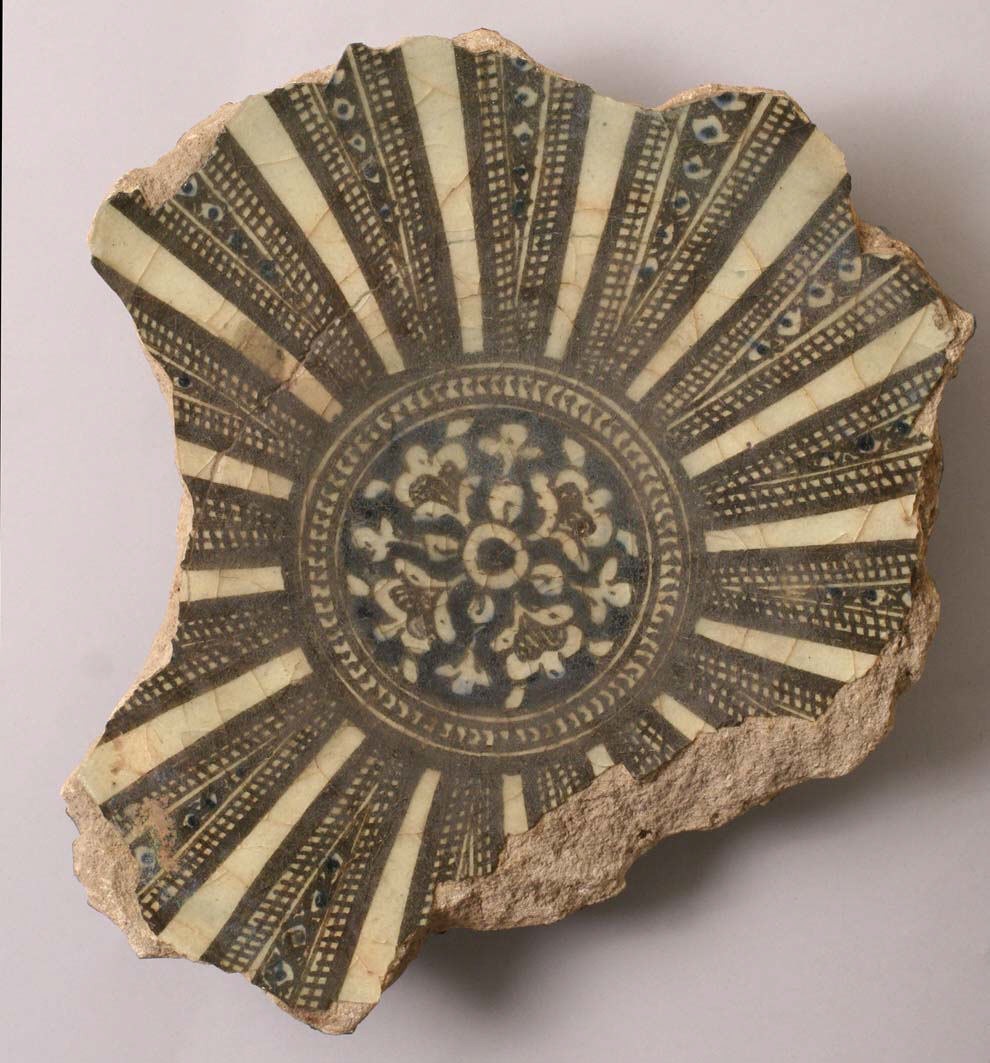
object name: fragment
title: Fragment of a Bowl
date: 1301-1400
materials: glaze, stonepaste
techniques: underglaze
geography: syria